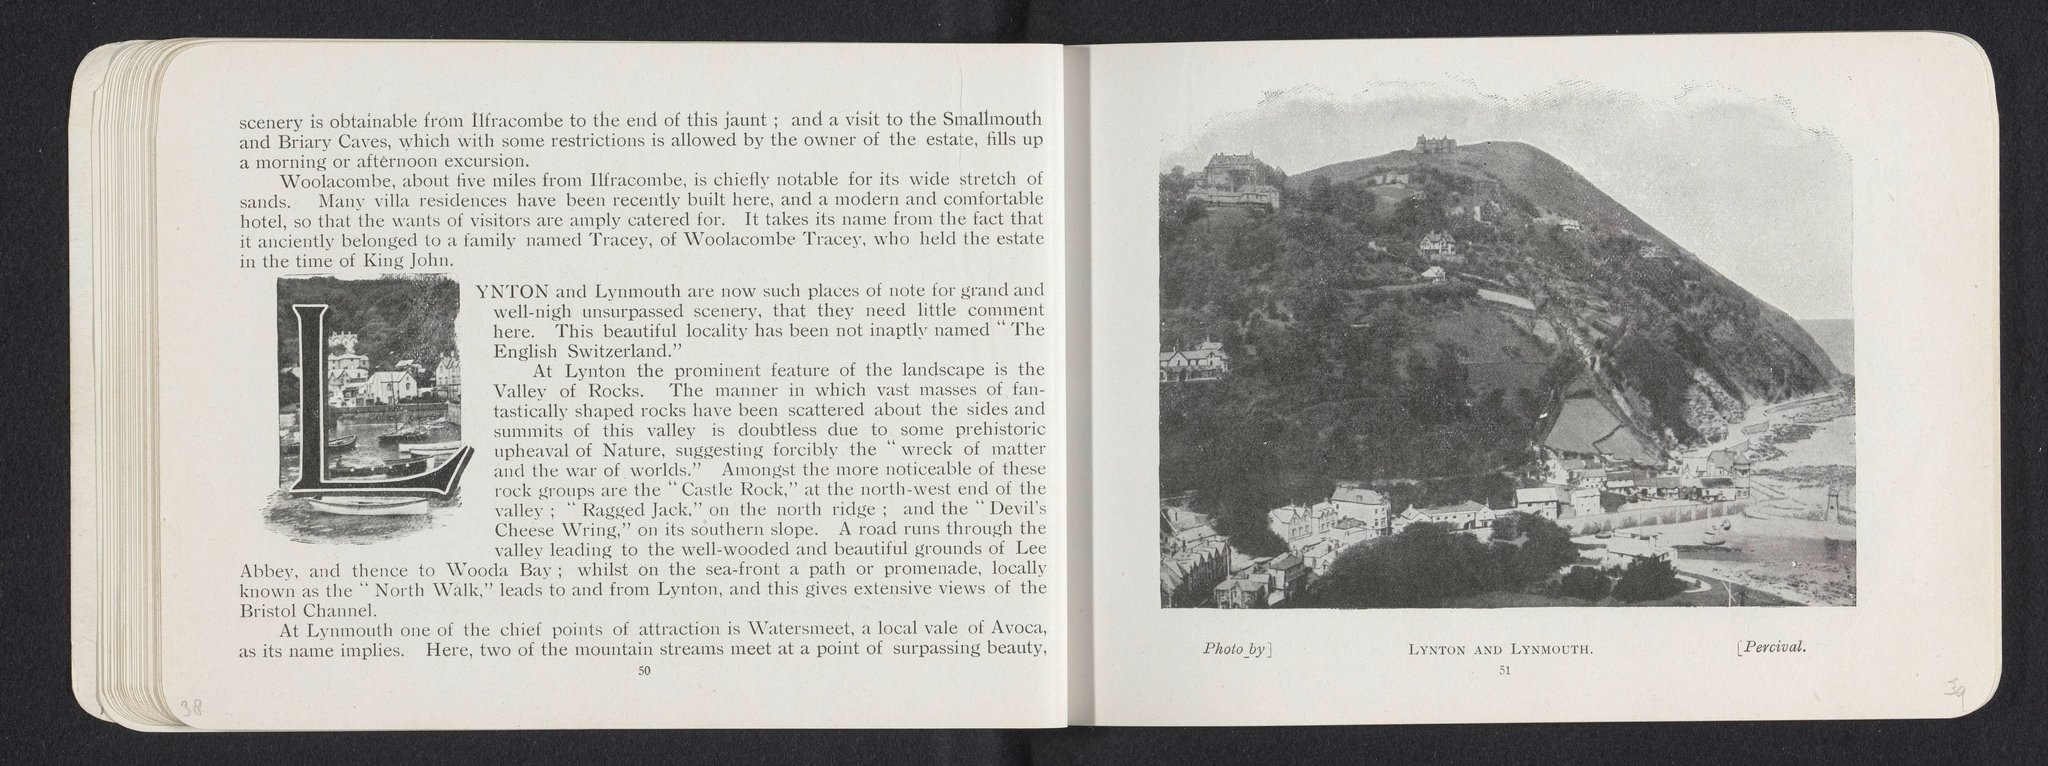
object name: page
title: Lynton and Lynmouth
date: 1900-1920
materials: paper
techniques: autotype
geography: devon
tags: city-view in general; 'veduta'